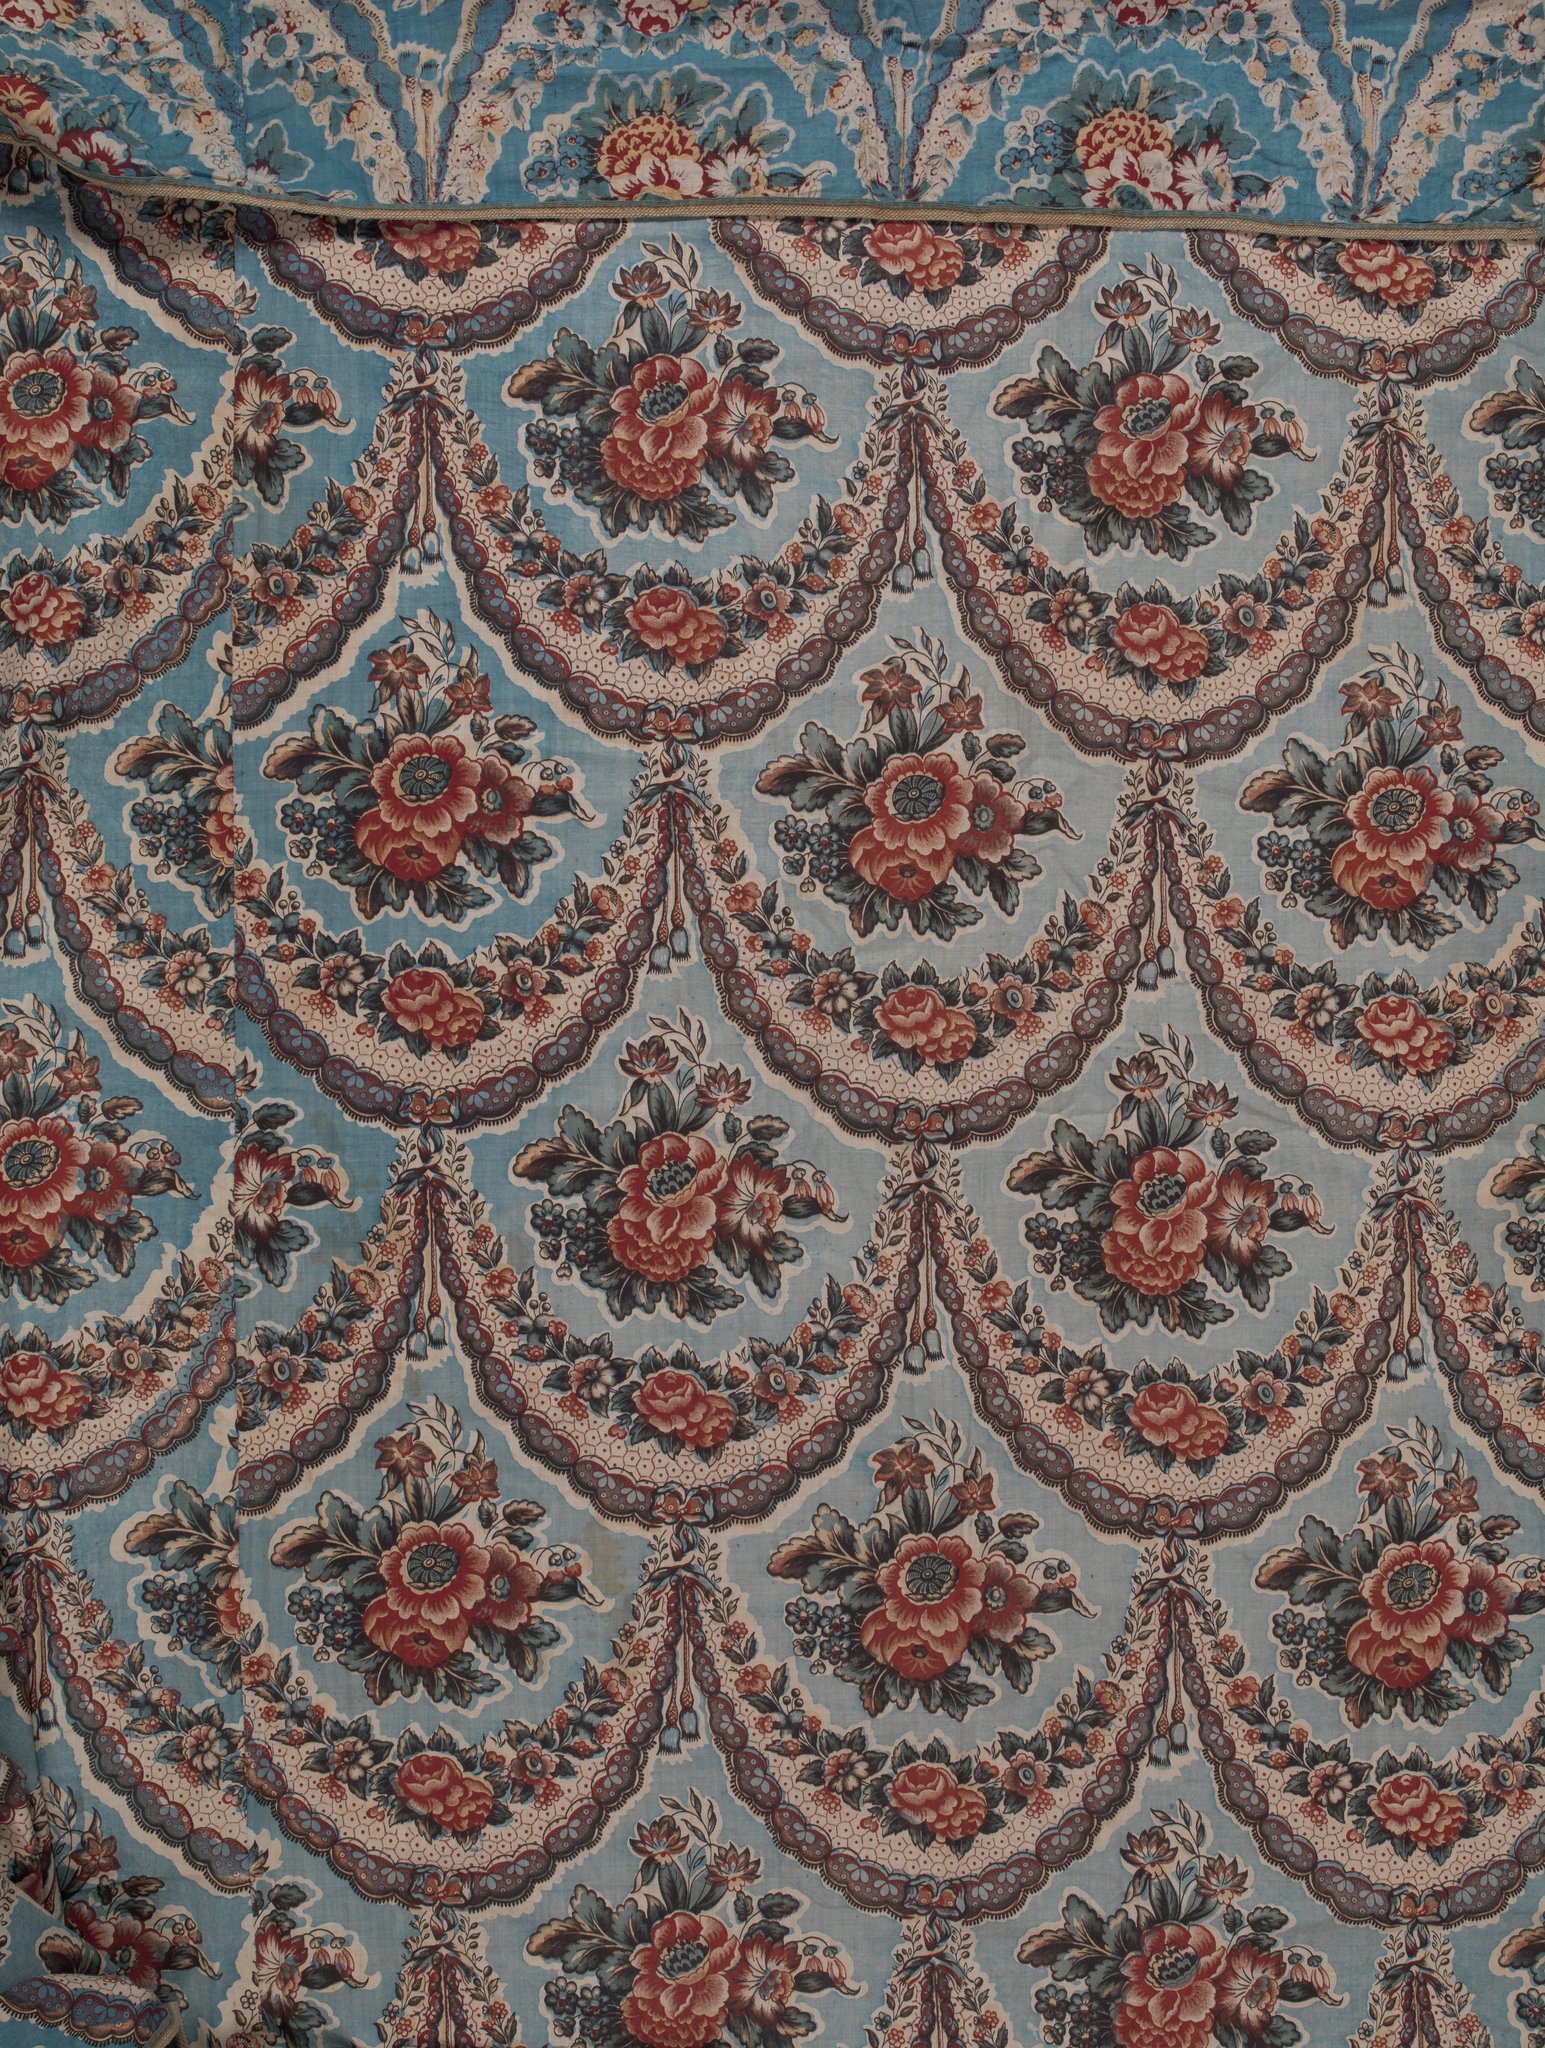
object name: length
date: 1826-1850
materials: cotton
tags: garlands,flowers